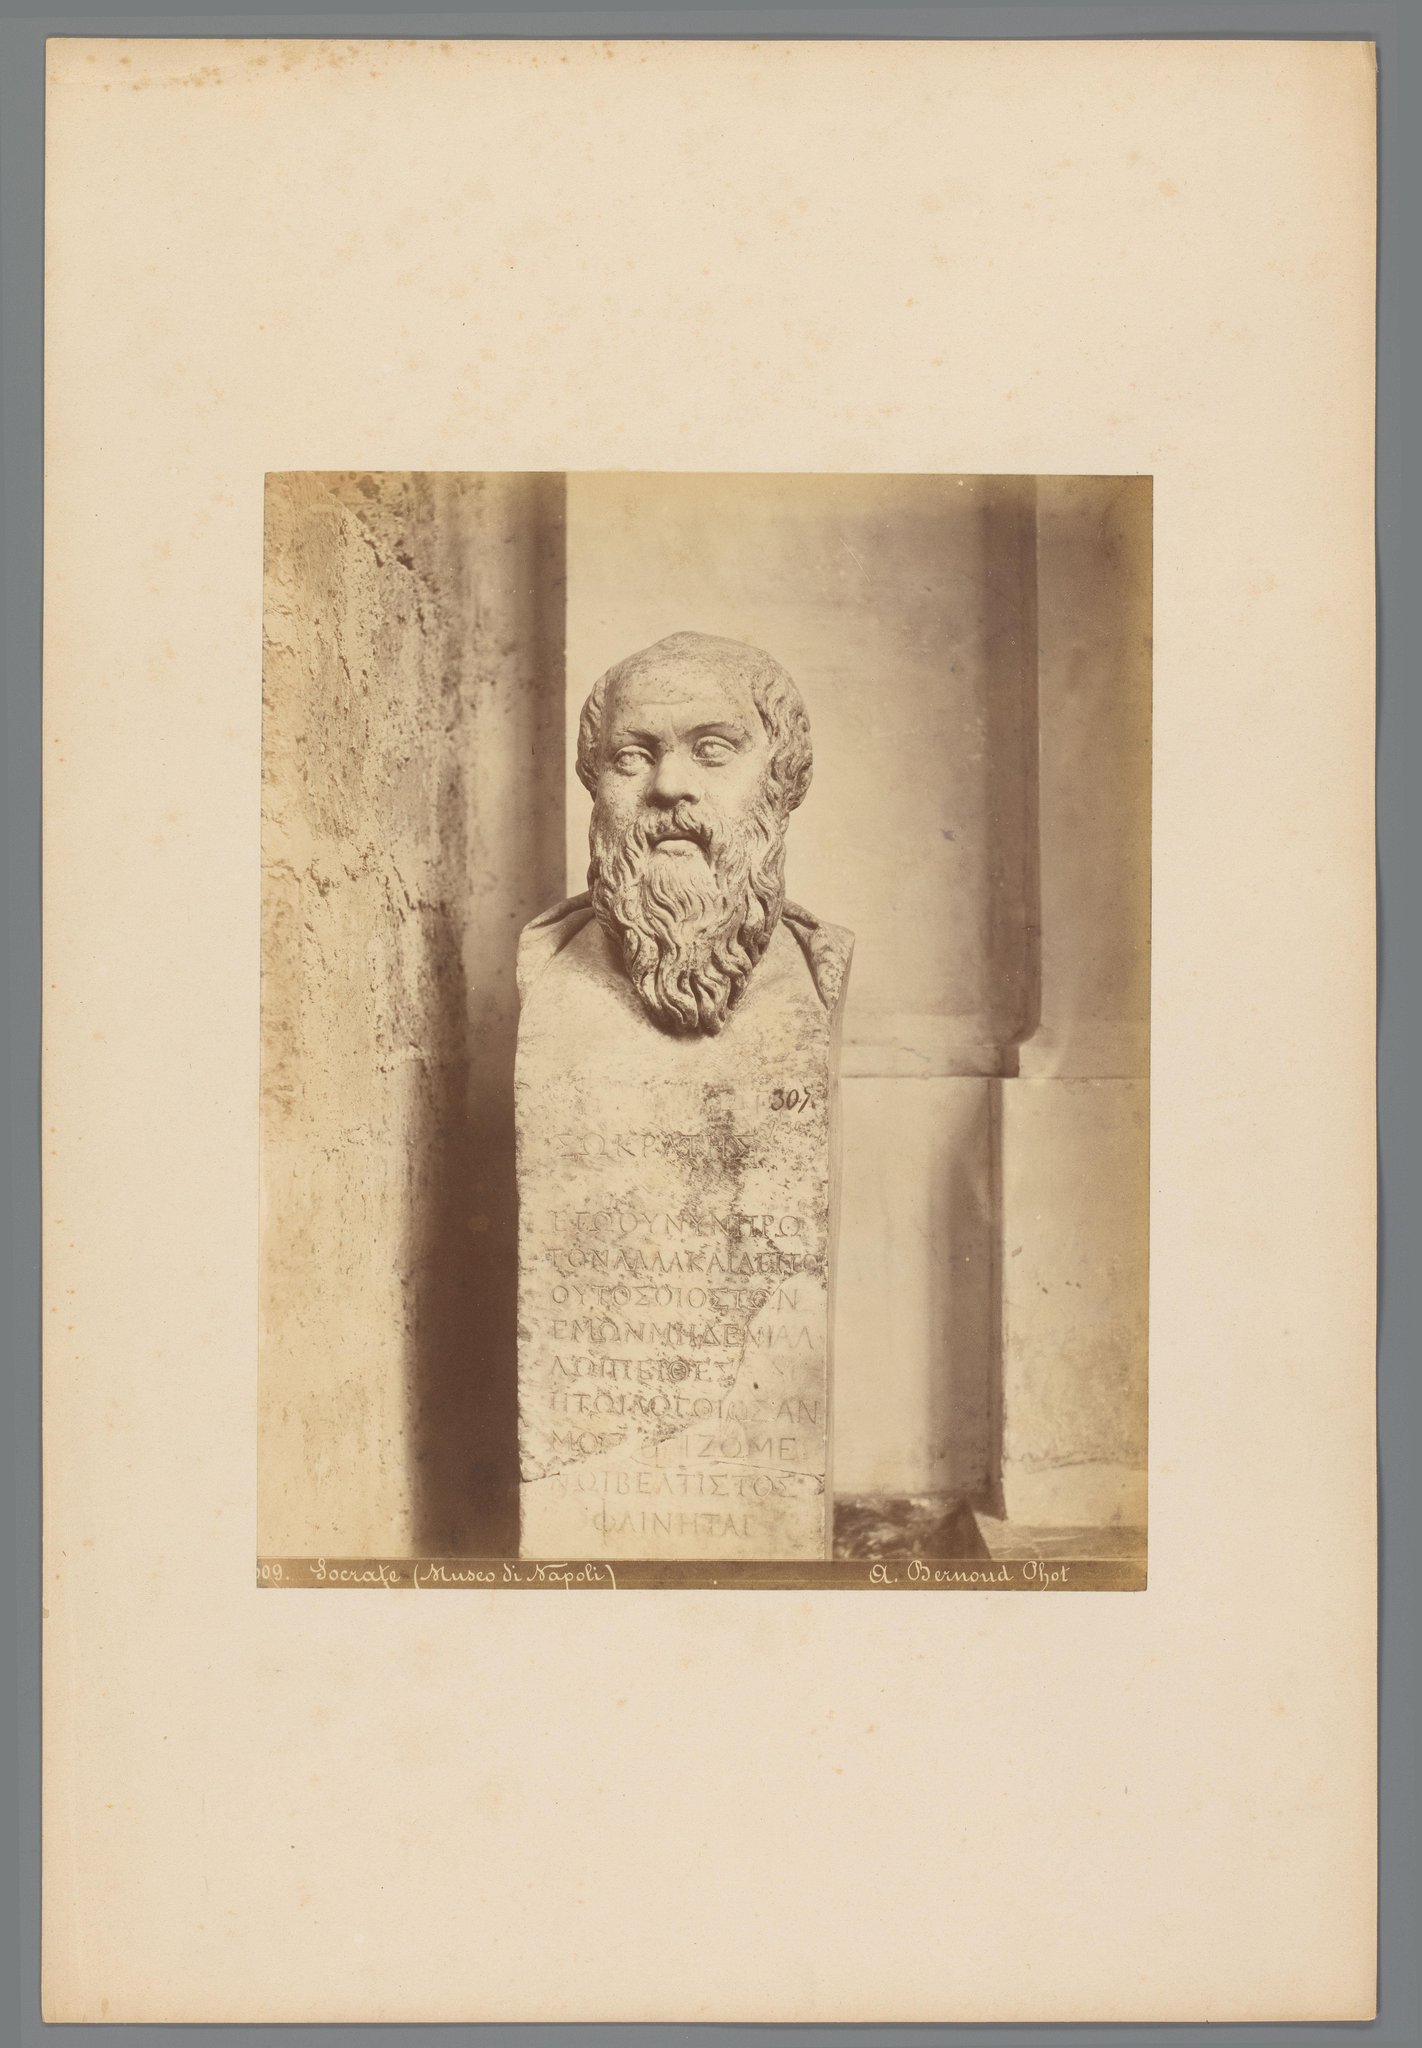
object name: photograph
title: (Museo di Napoli)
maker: alphonse bernoud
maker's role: fotograaf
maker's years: 1820-1889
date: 1851-1873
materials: cardboard, paper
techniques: albumen print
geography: naples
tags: head (human), piece of sculpture, reproduction of a piece of sculpture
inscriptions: number: ‘[...]09’